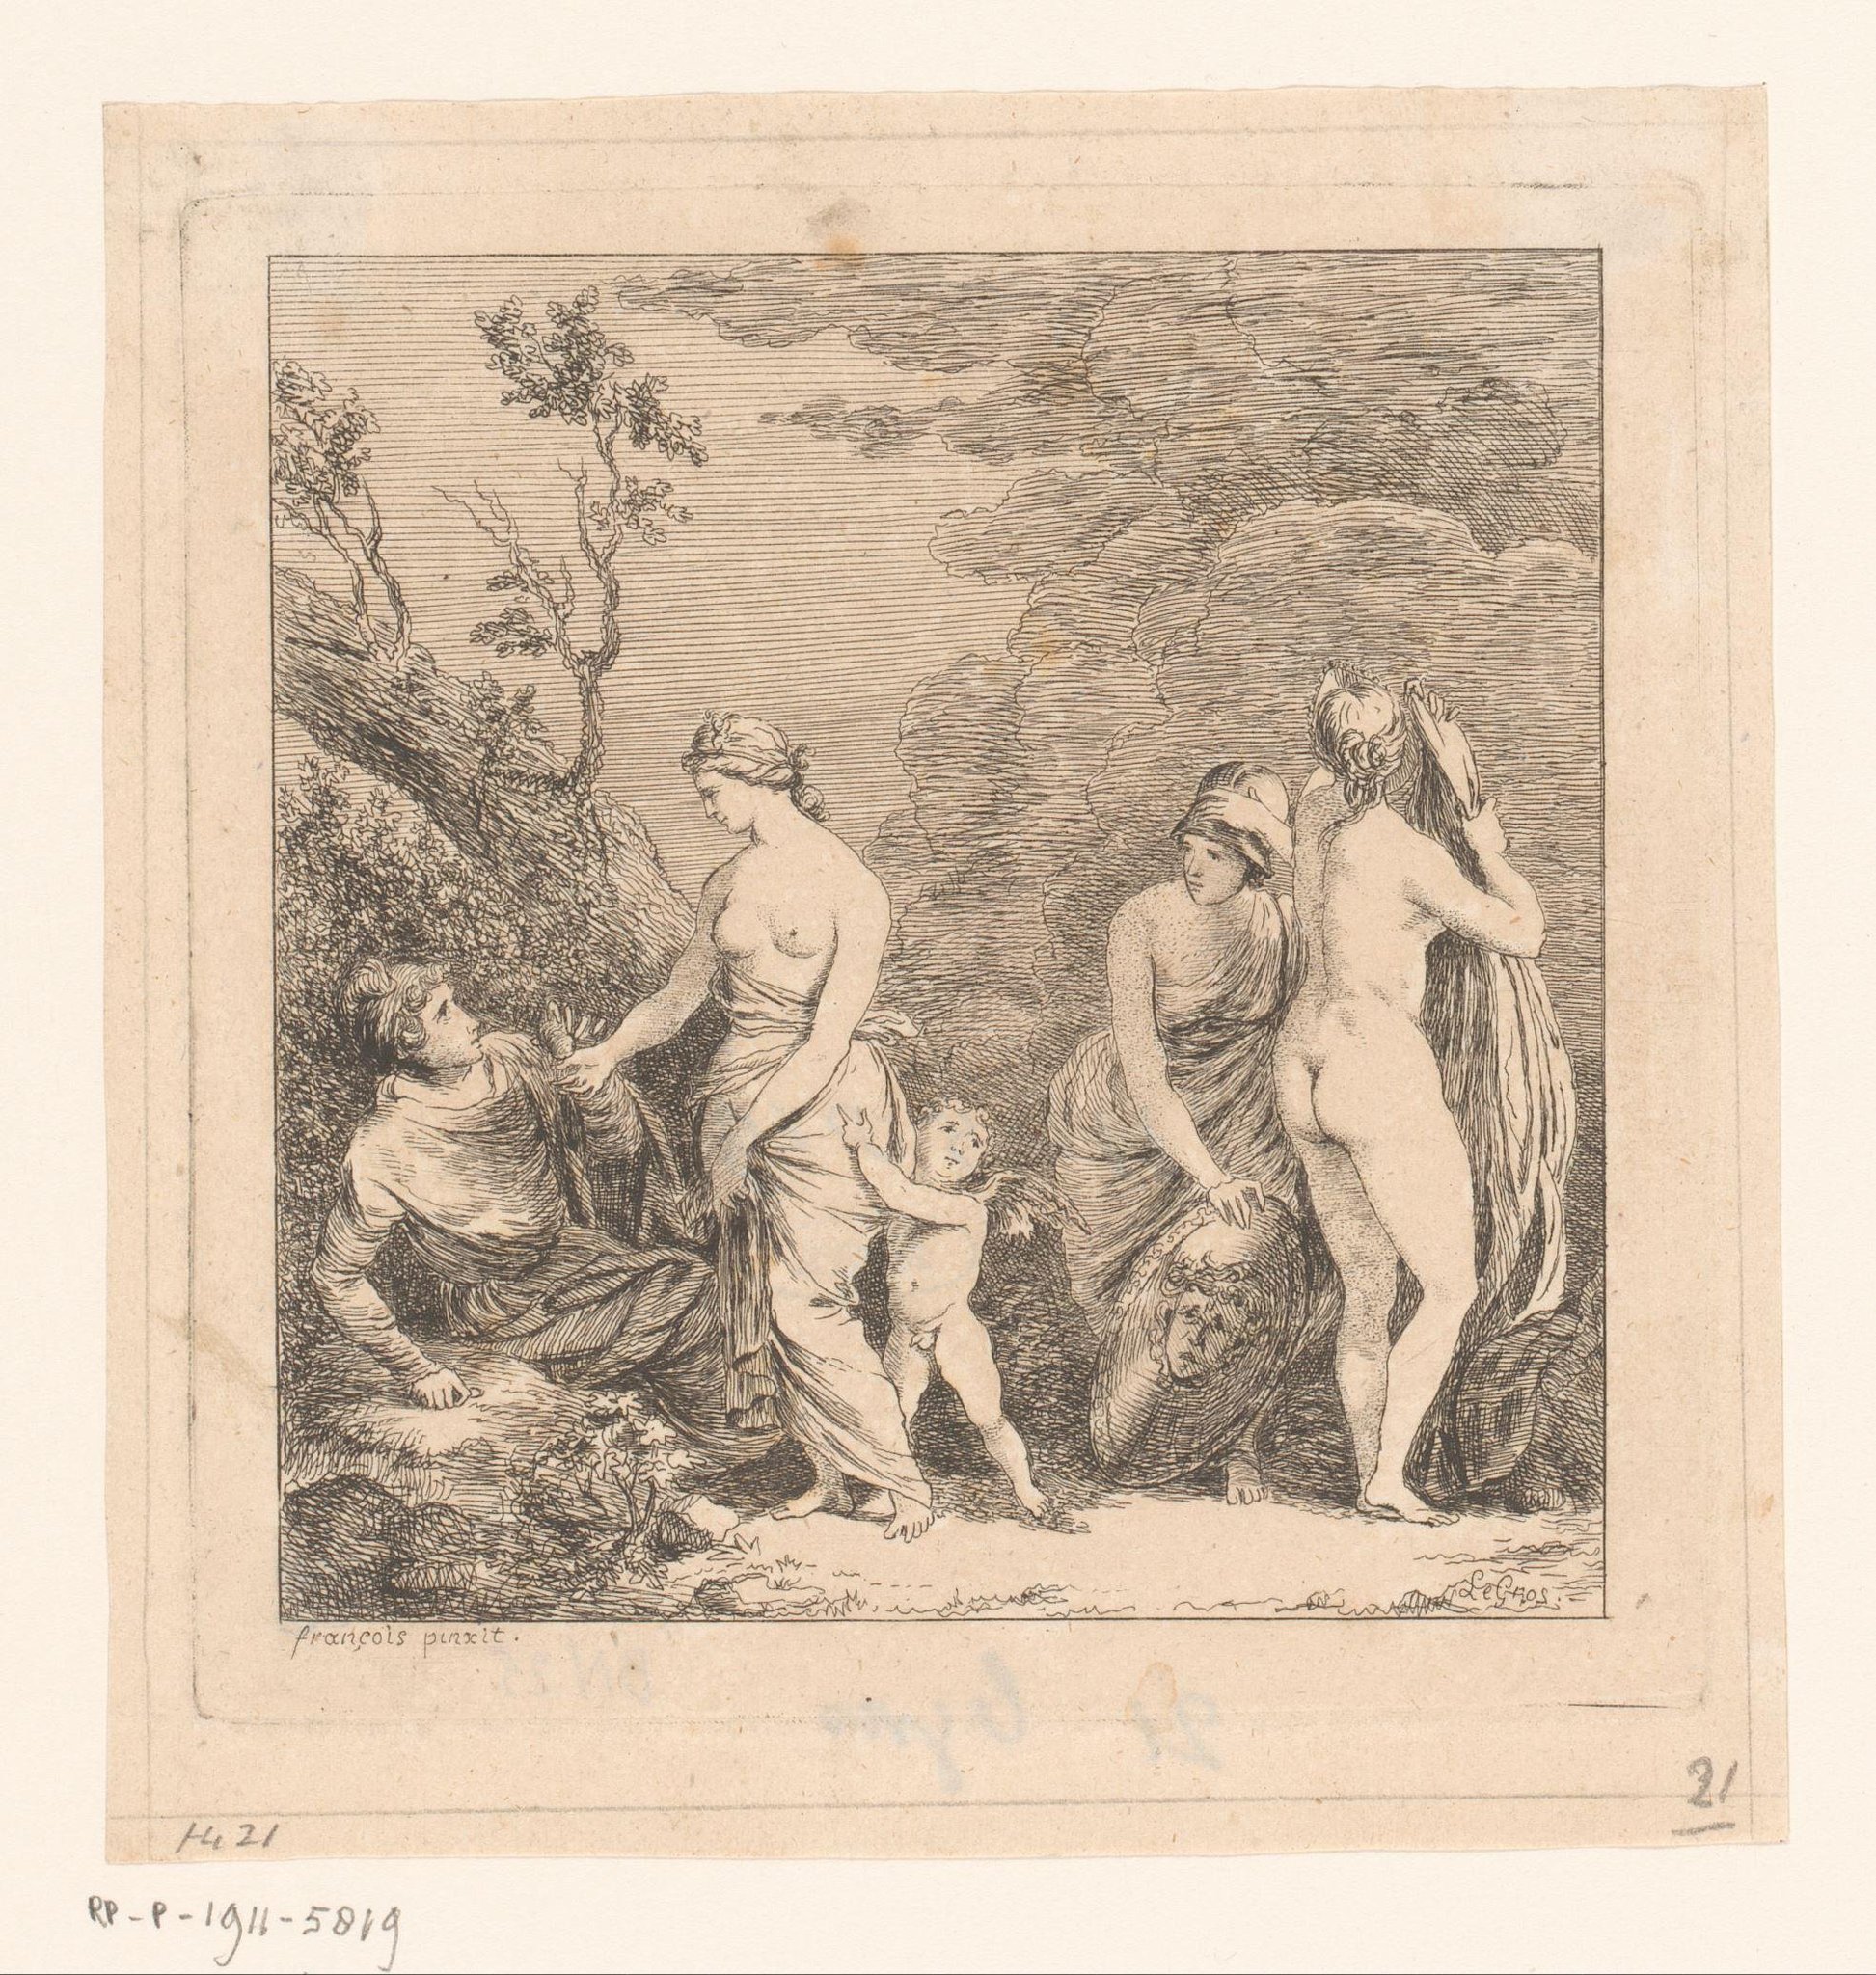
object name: print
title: Oordeel van Paris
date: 1764-1834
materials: paper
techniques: etching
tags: the judgement of paris (without mercury)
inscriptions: collector's mark: Lugt 1485, collector's mark: Lugt 2228